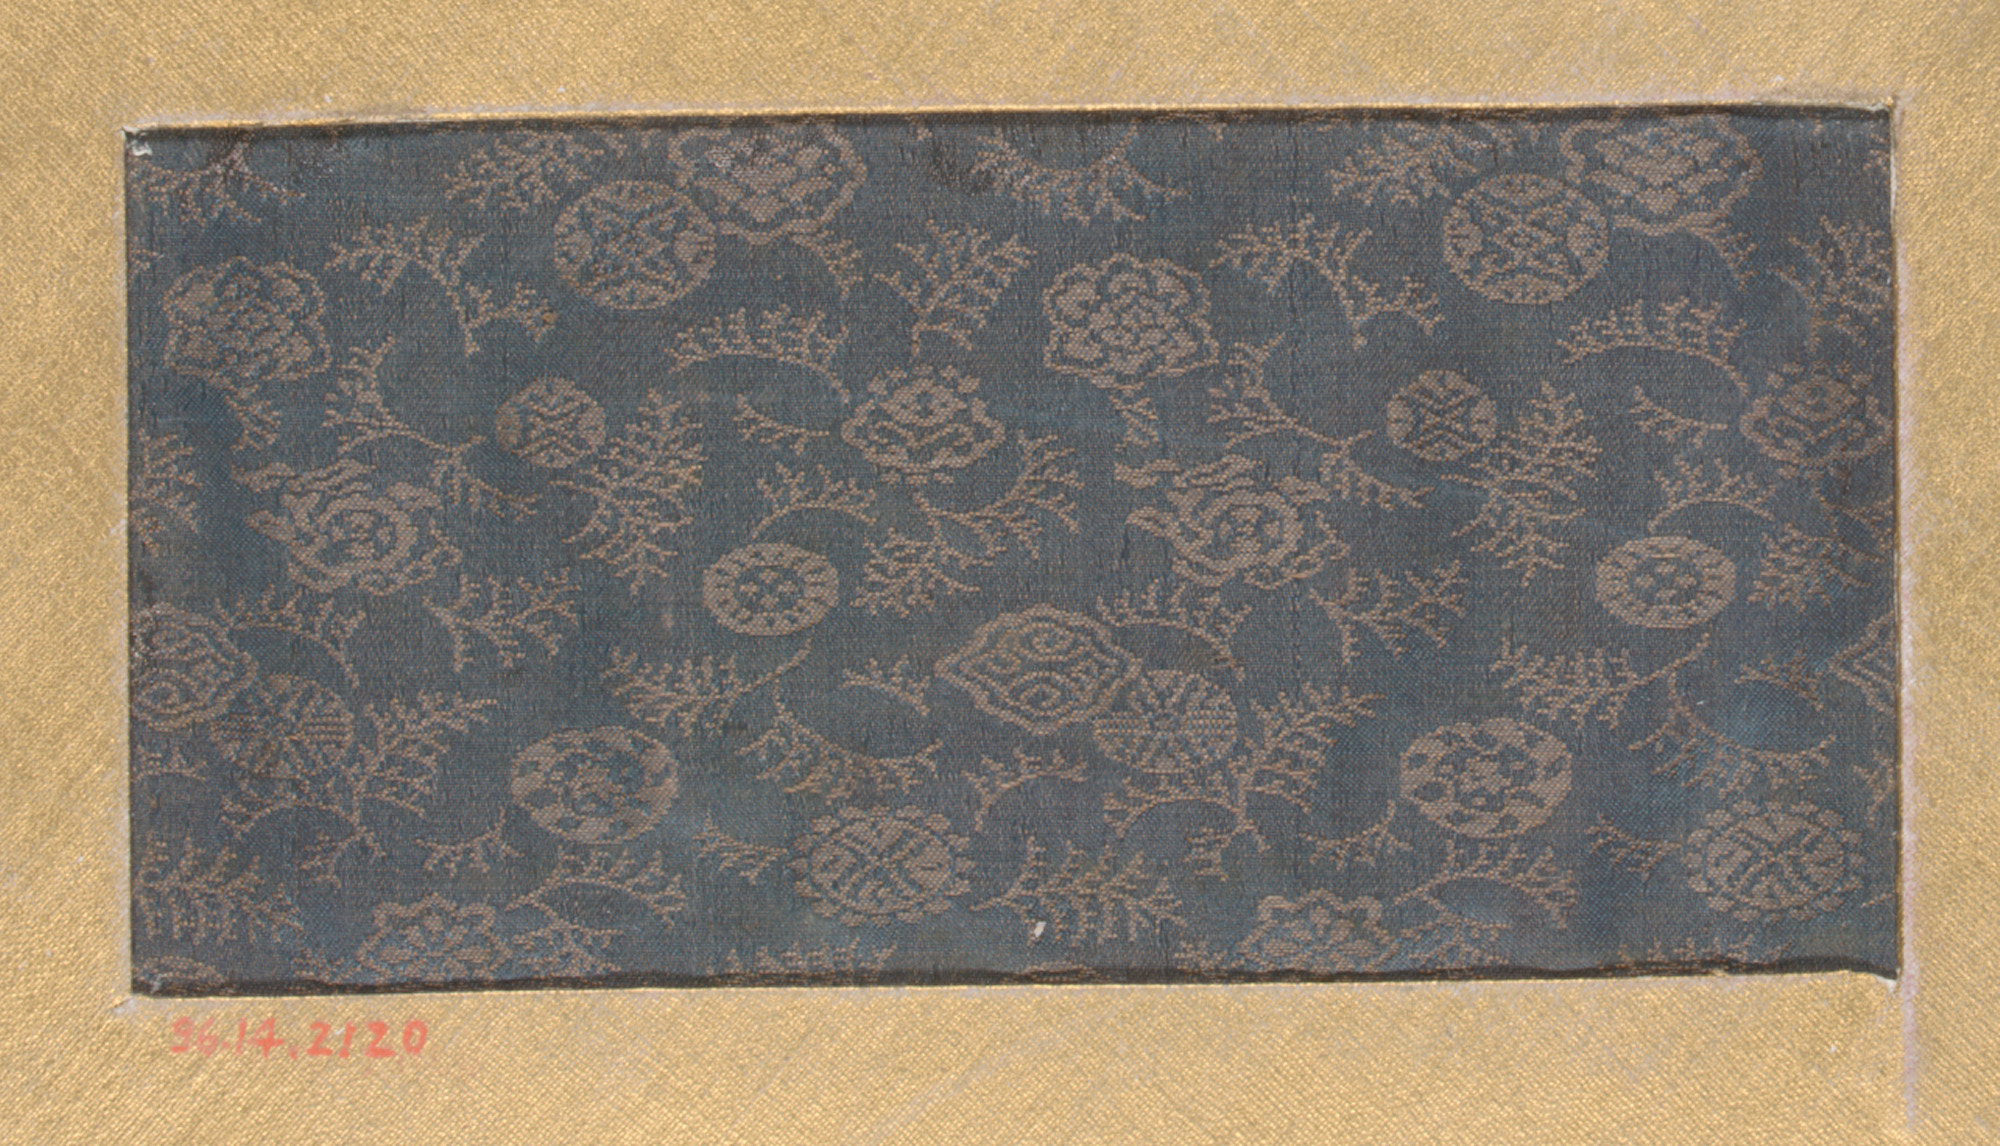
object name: piece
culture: japanese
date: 1701-1900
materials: silk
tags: flowers